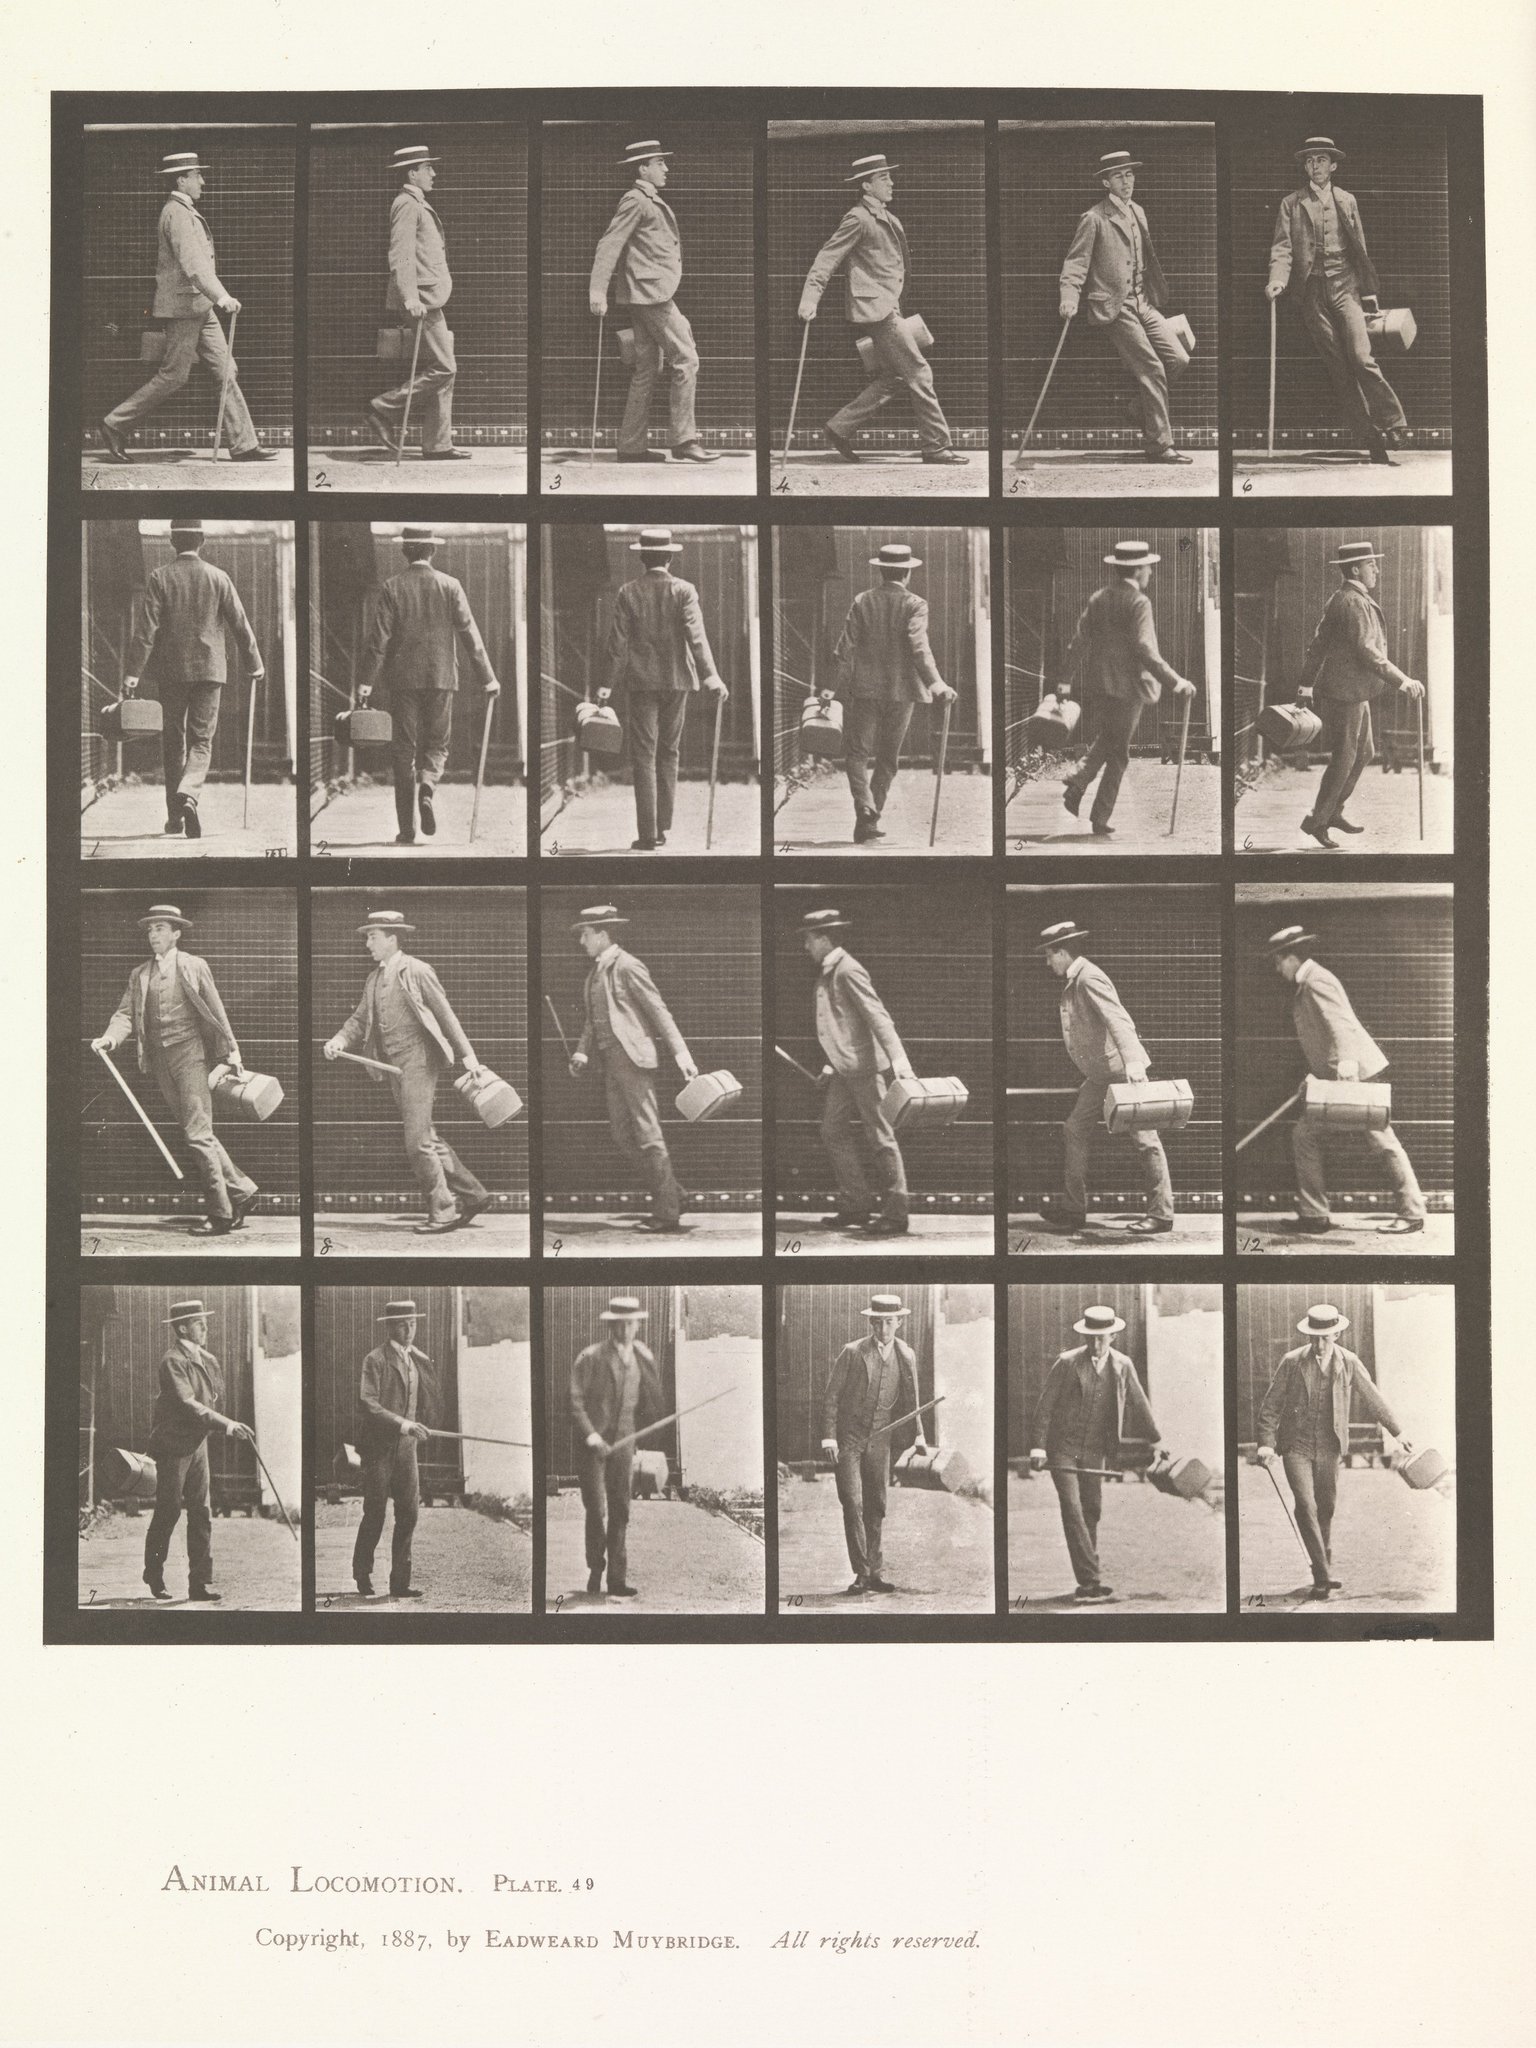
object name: photographically illustrated book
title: Animal Locomotion. An Electro-Photographic Investigation... of Animal Movements. Commenced 1872 - Completed 1885. Volume VII, Men and Woman (Draped) Miscellaneous Subjects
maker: eadweard muybridge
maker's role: artist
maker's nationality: british and american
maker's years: 1830-1904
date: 1880-1889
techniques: photogravure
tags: men,women,dancing